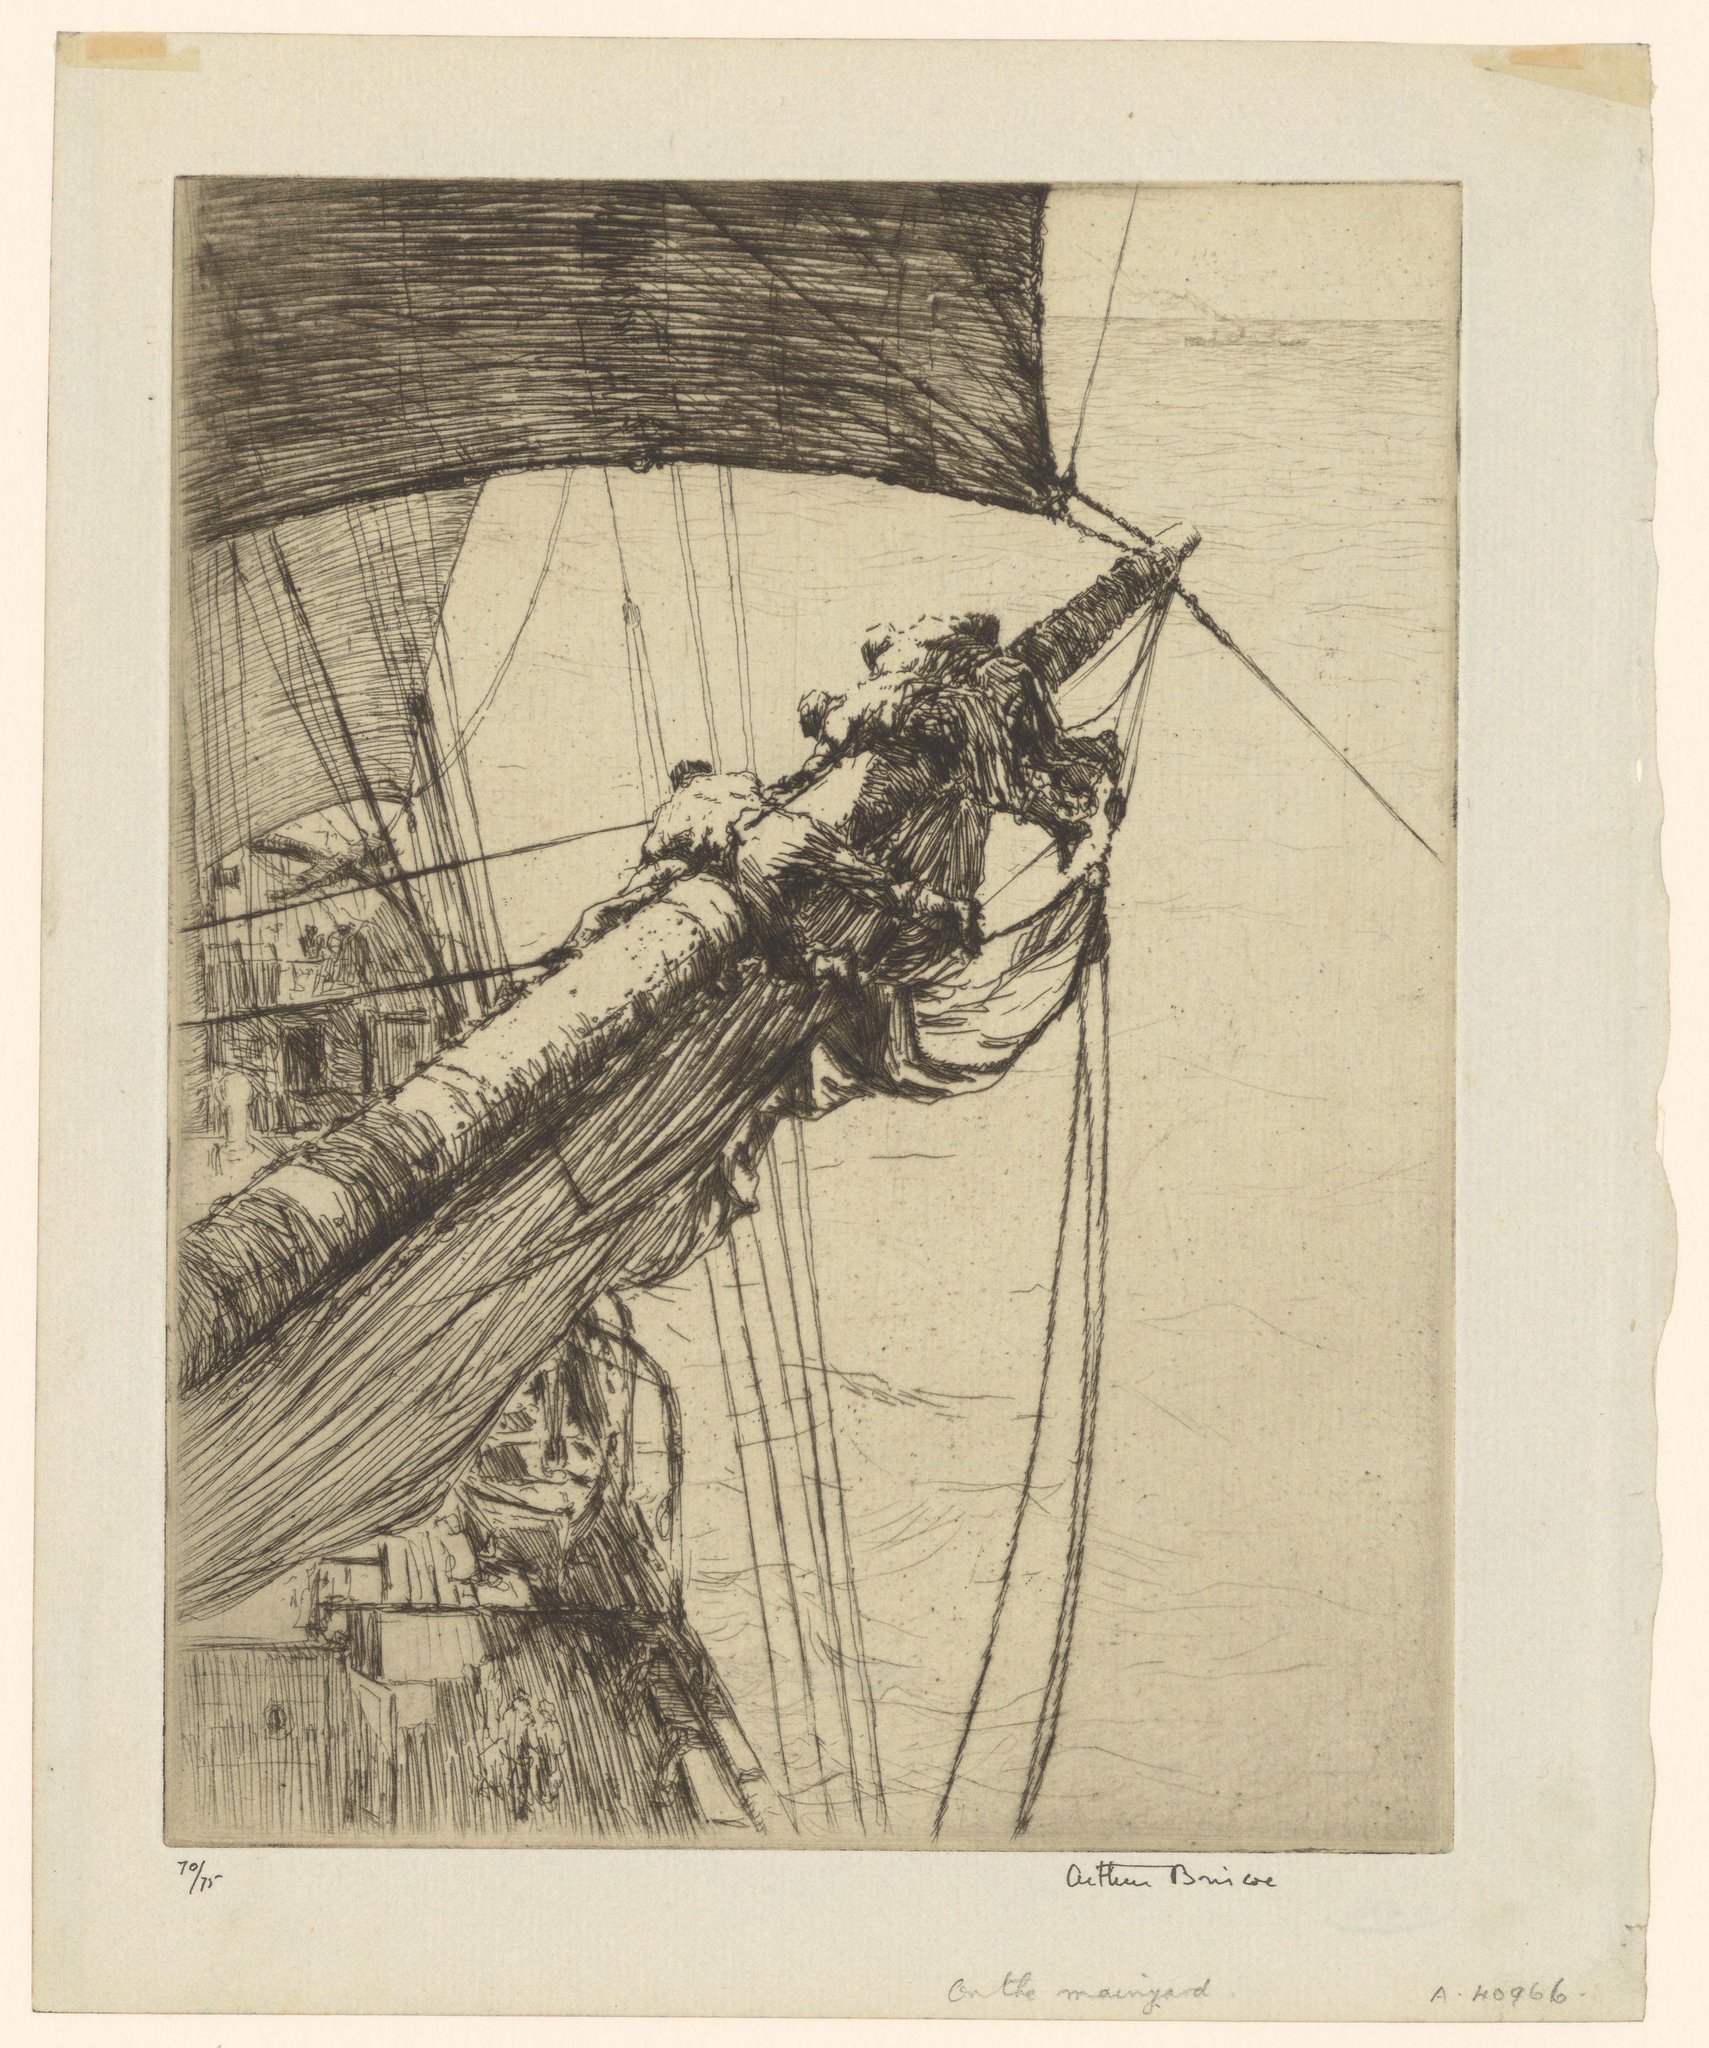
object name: print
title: On the Mainyard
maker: arthur john trevor briscoe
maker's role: print maker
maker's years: 1873-1943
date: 1925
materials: paper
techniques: drypoint, etching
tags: sailing-ship's rigging, sailing-ship, sailing-boat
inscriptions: collector's mark: Lugt 2228